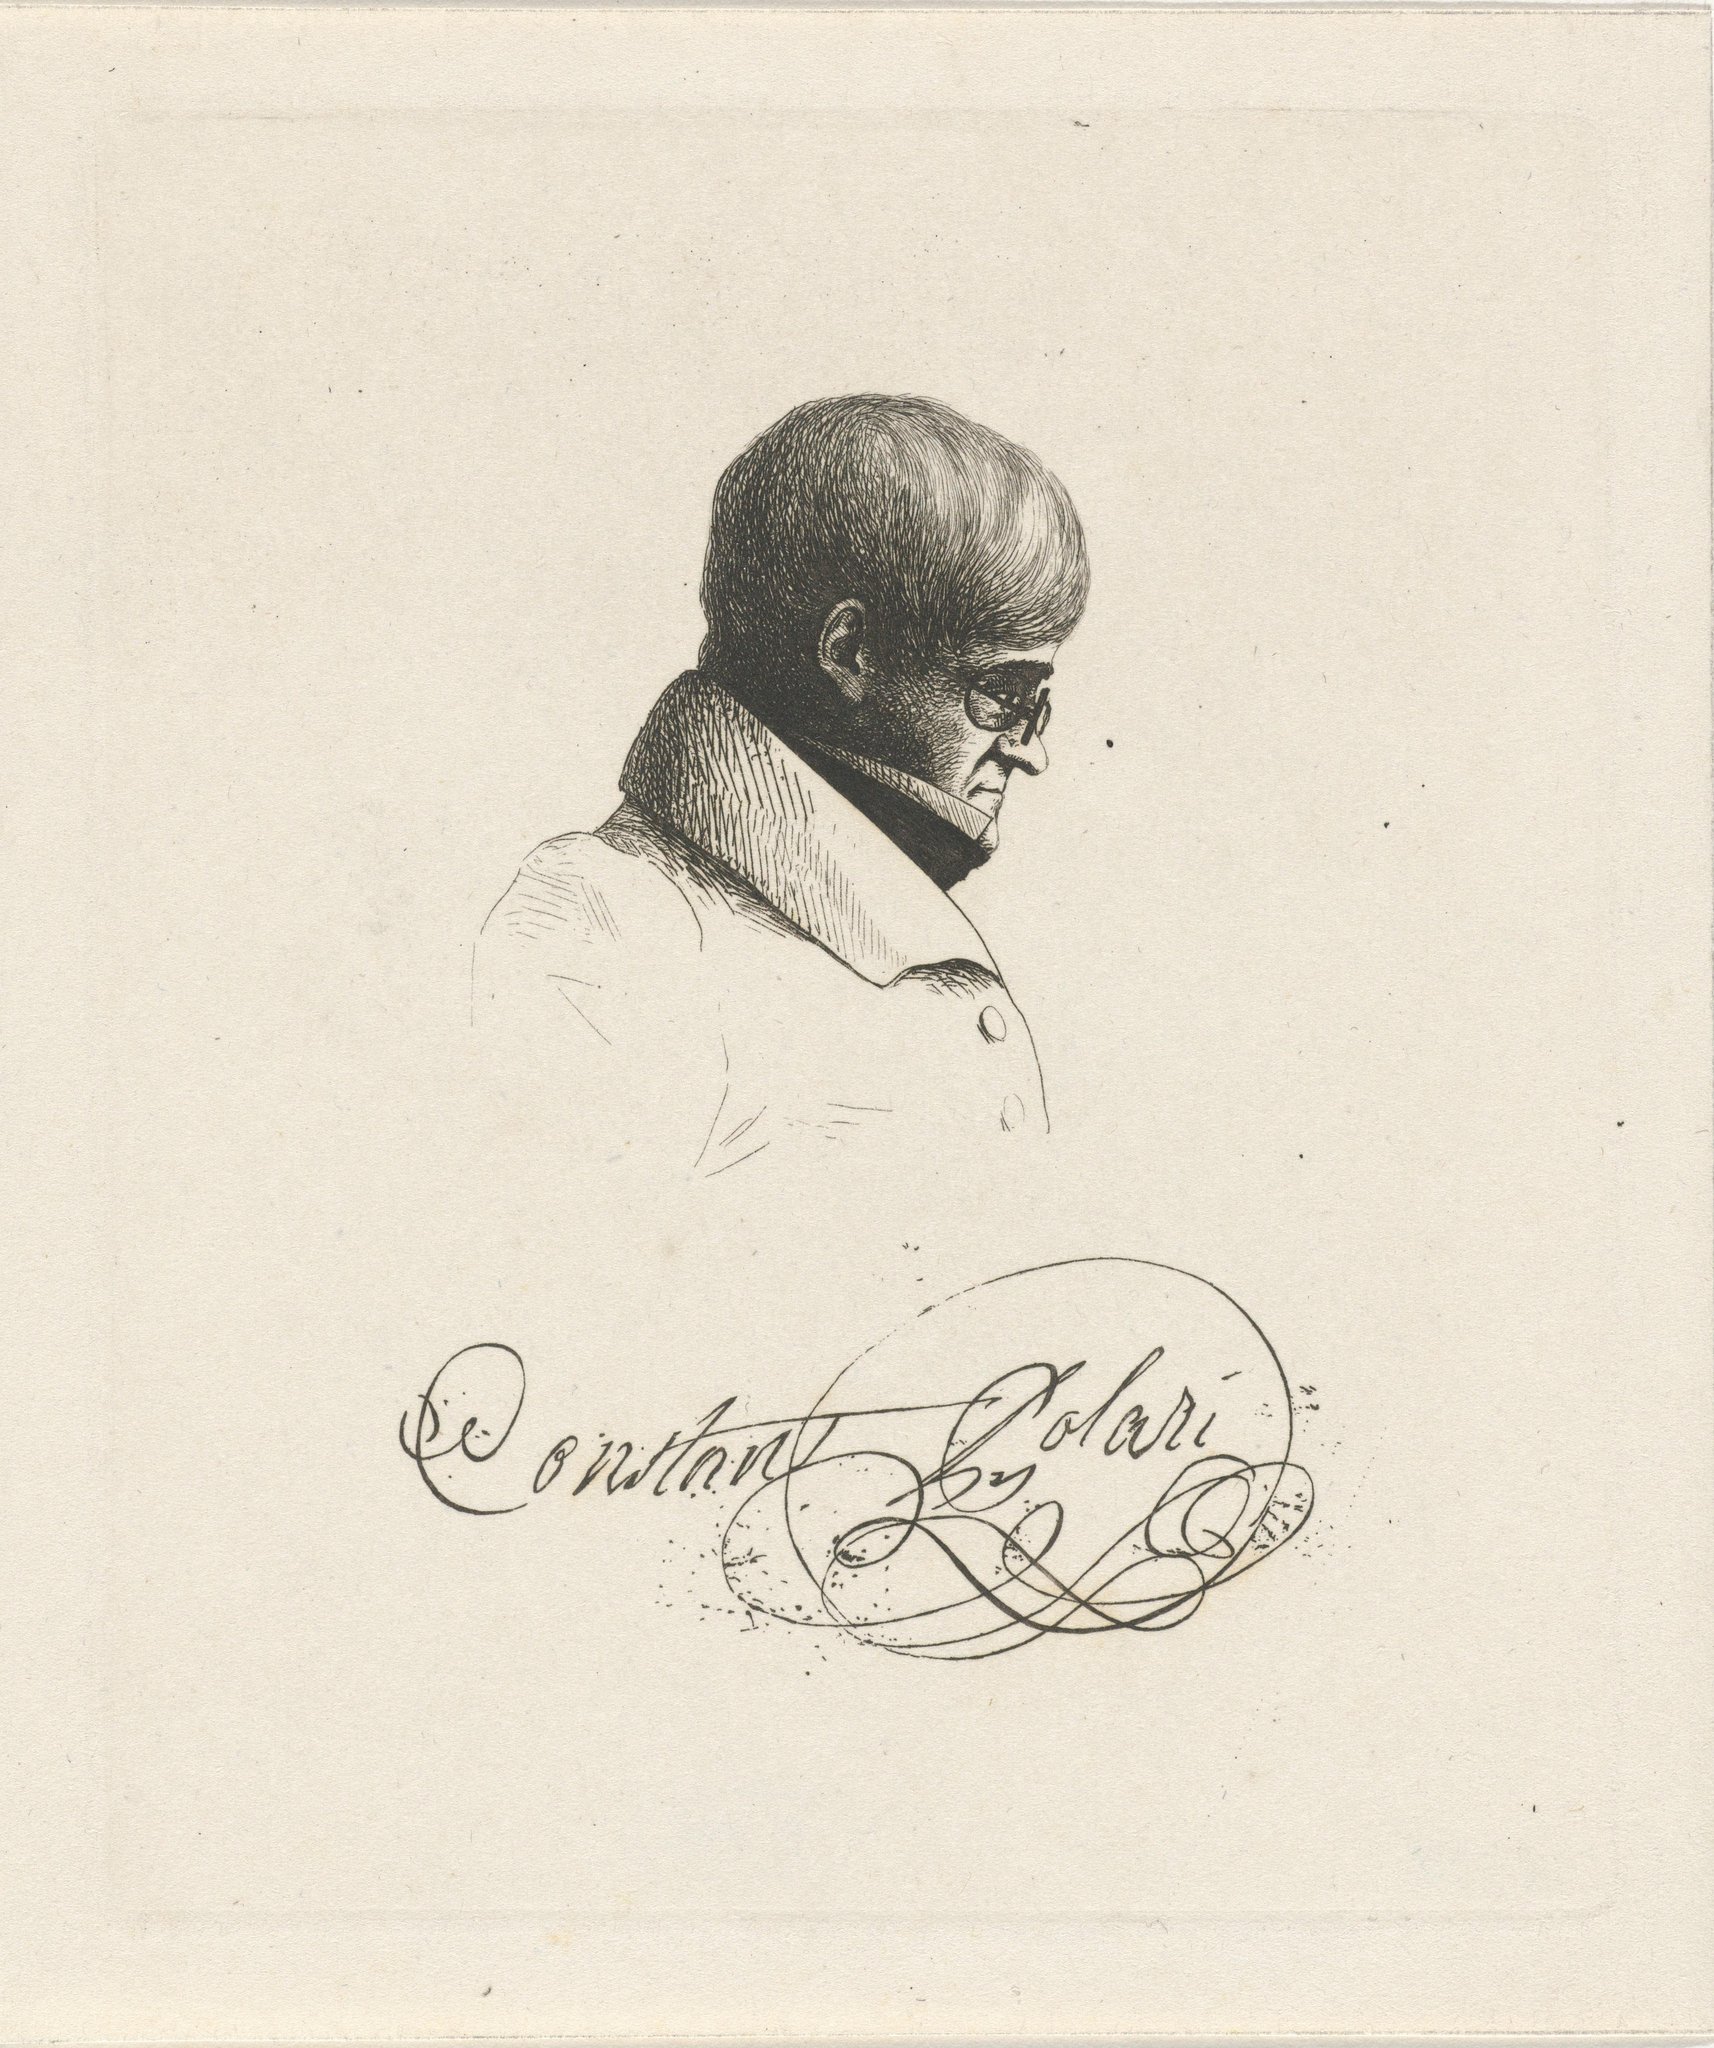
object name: print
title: Portret van Constant Polari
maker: jean zacherie mazel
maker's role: draughtsman, print maker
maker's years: 1792-1884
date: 1835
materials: paper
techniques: etching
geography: netherlands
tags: eyeglasses, spectacles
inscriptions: collector's mark: Lugt 2228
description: Prent mogelijk uit: Arntzenius, Pieter Nicolaas. Procès de Constant Polari, condamné le 8 mars 1834, par la Cour d'Assises de la Hollande, (partie Méridionale), pour cause de vol des diamans et joyaux de Madame la Princesse d'Orange. Den Haag: Lejeune, 1835. Twee delen.